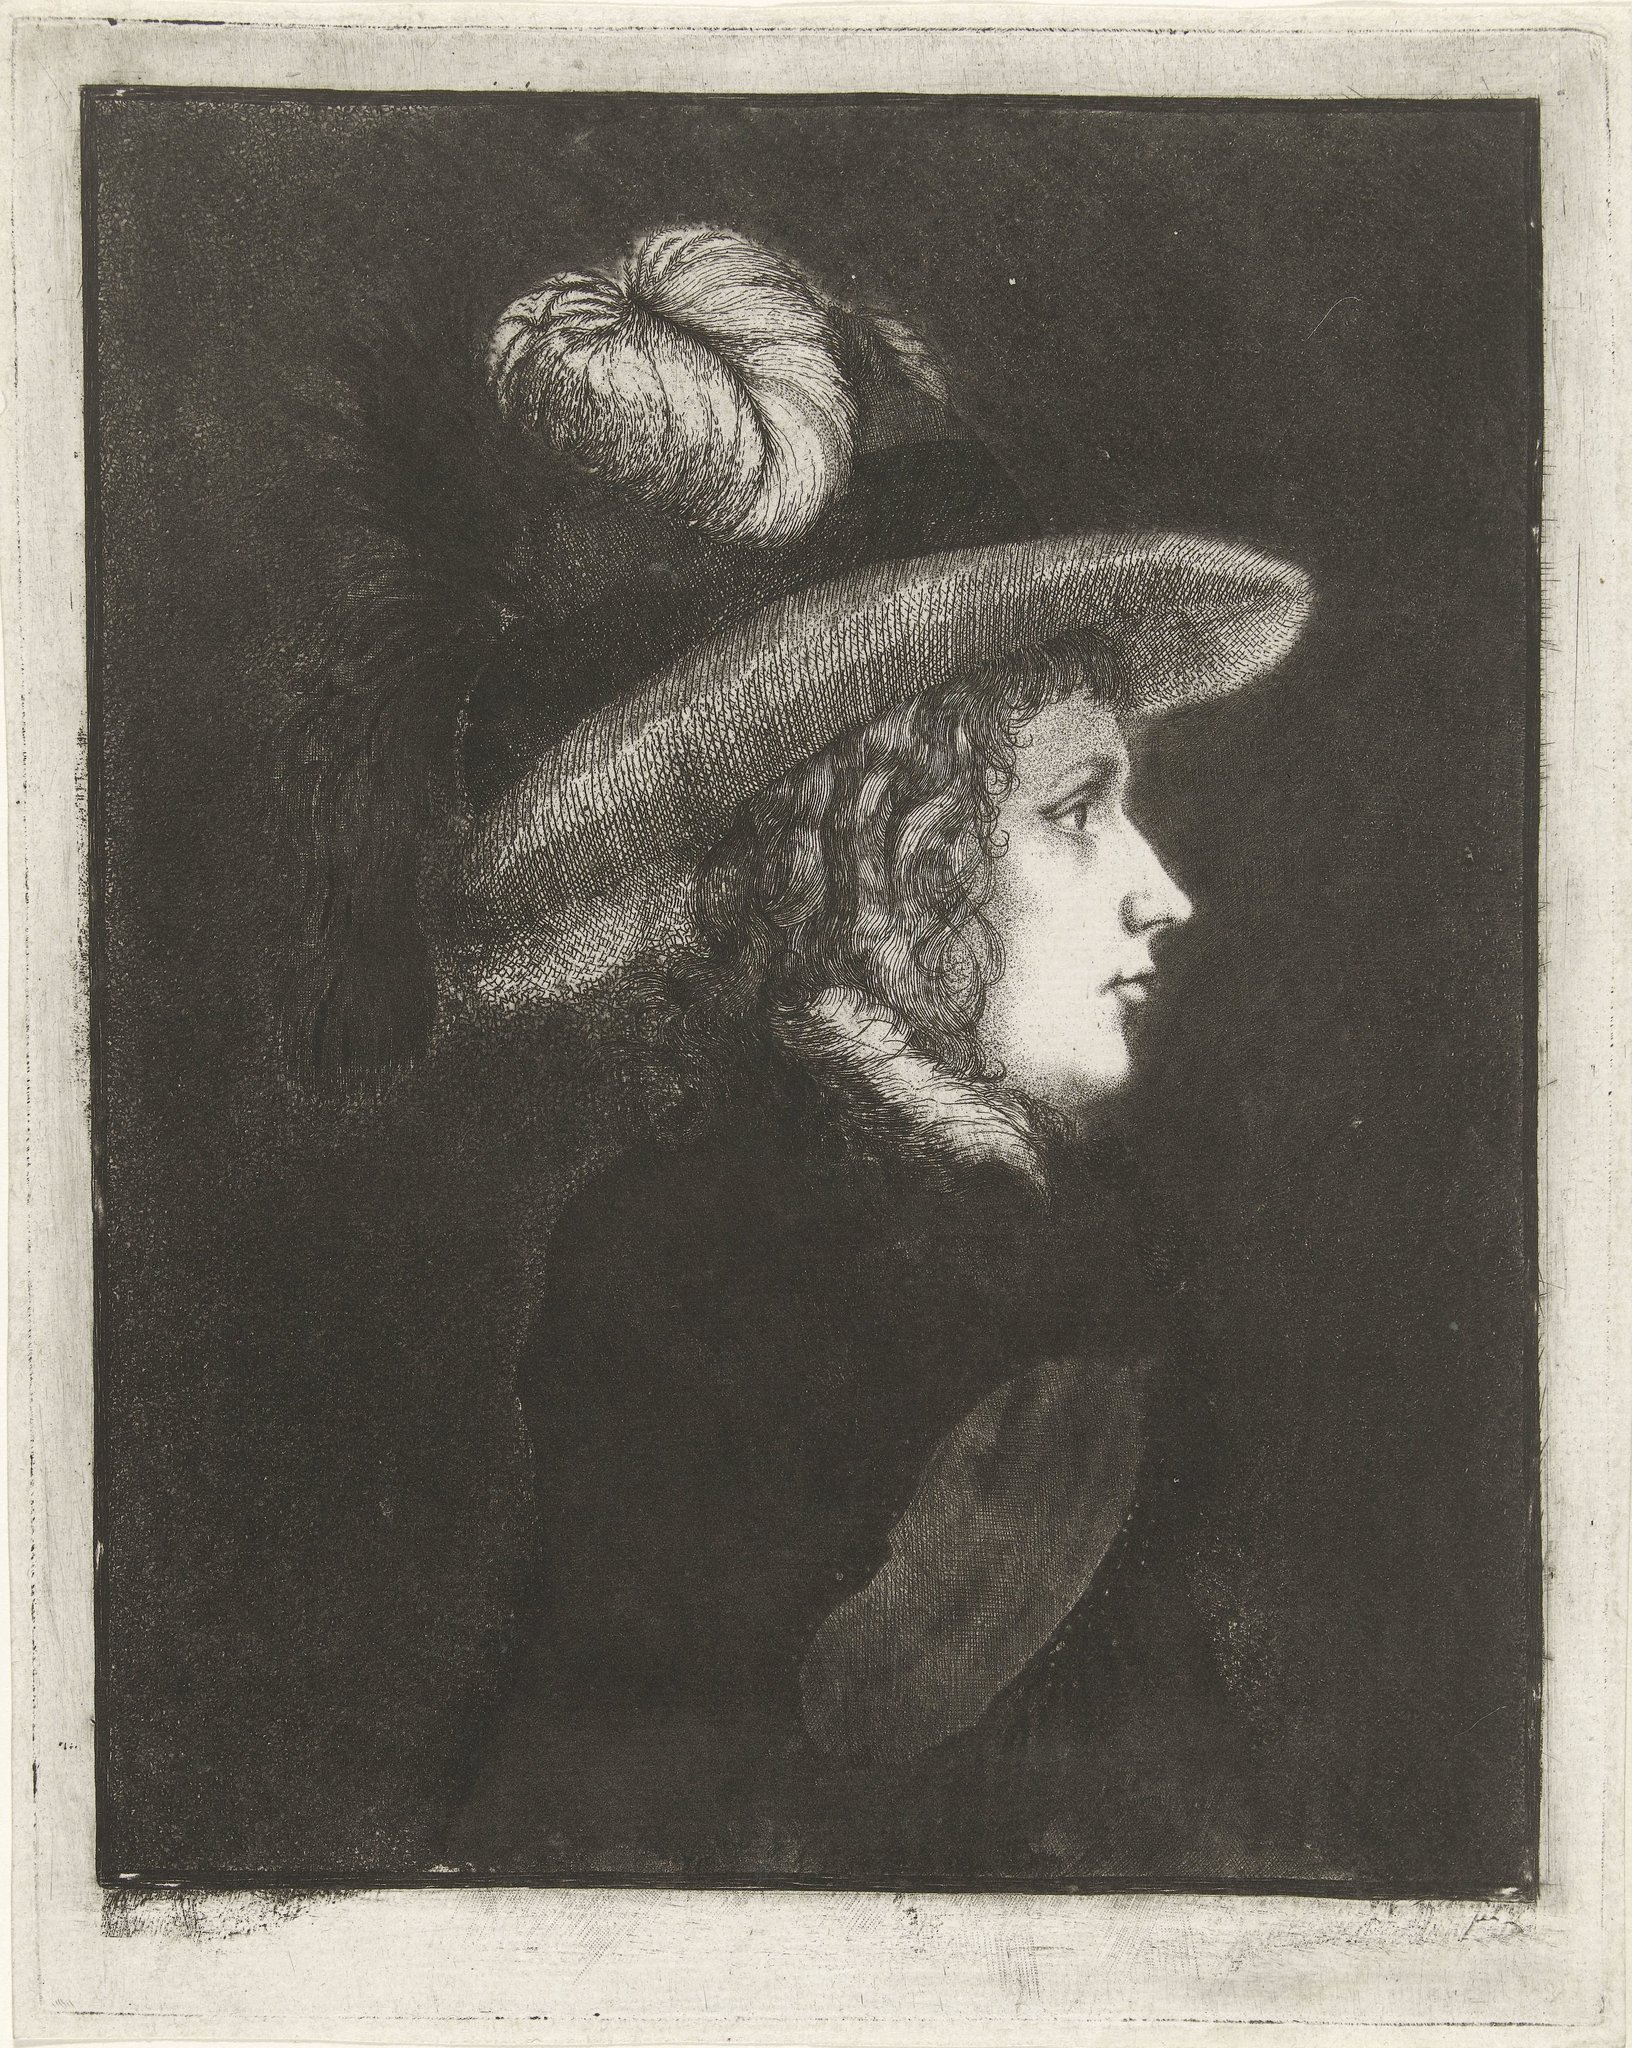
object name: print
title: Madame Hazard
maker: james hazard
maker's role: print maker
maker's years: 1748-1787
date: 1758-1787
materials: chalk, paper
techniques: etching, roulette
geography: southern netherlands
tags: head-gear: hat (+ women's clothes), head-gear: hat (+ feathers used for clothes)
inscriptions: number: ‘RW.15454 No. 75’, collector's mark: Lugt 2228, inscription: ‘Madame Hazard/ out plutot:/ [...] James Hazard/ tres rare’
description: Buste naar rechts van een vrouw met een hoed met opstaande en afhangende veren.